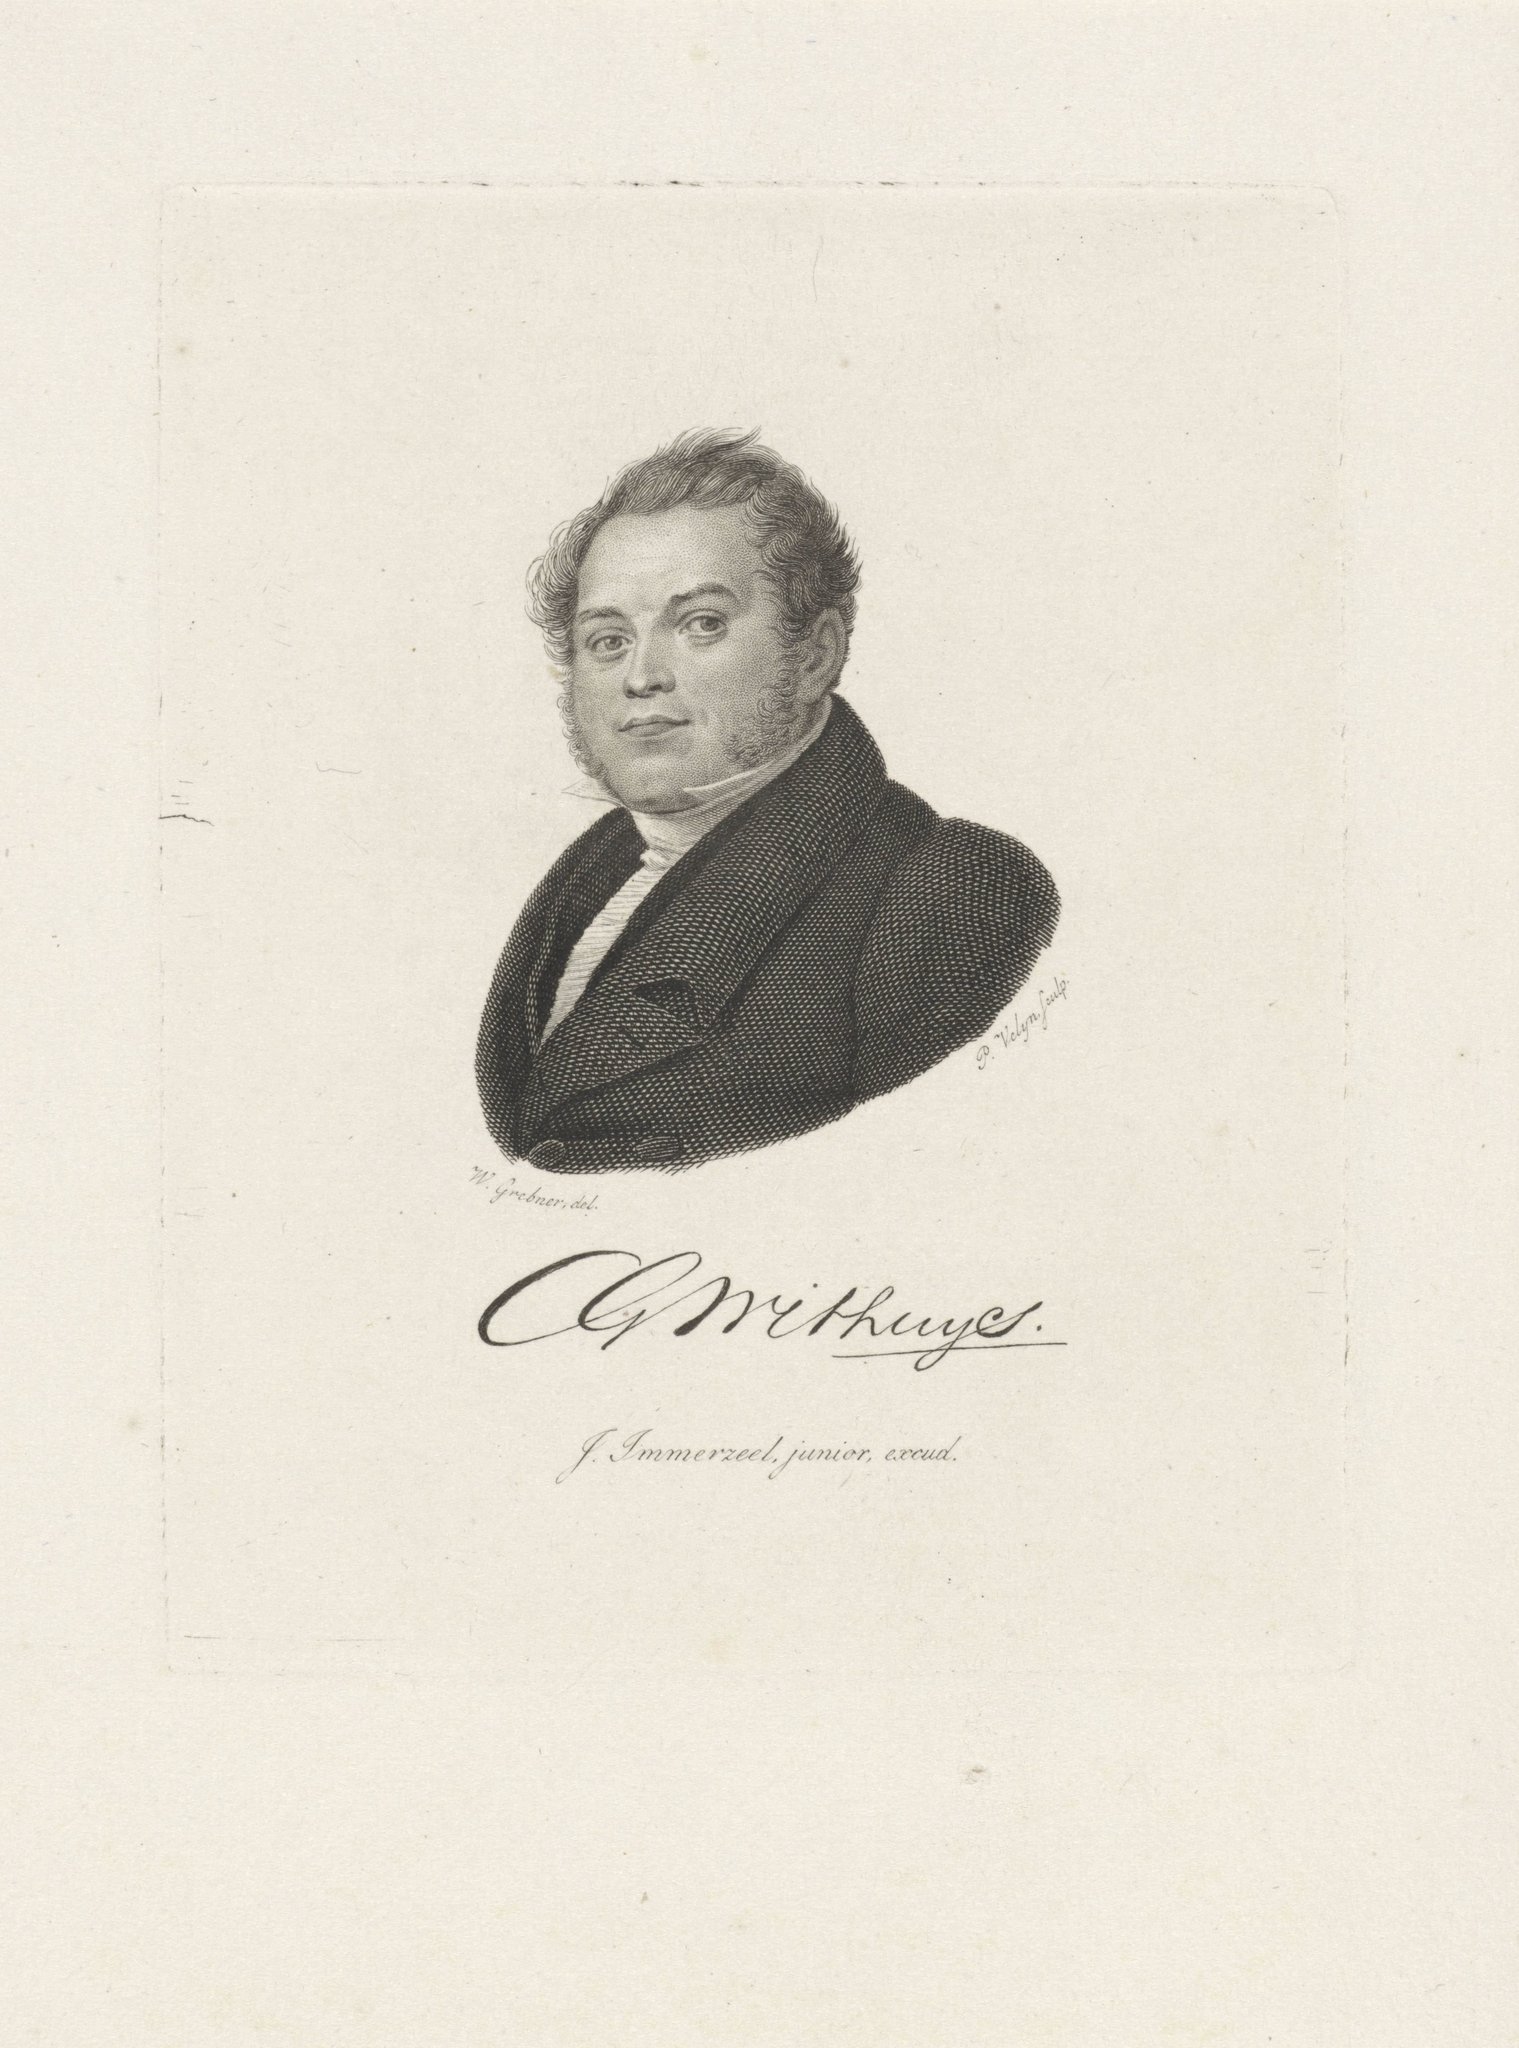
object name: print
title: Portret van Carel Godfried Withuys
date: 1831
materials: paper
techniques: engraving, etching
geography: netherlands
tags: amsterdam, the hague, publisher, carel godfried withuys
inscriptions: collector's mark: Lugt 2228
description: Prent volgens Van Someren gebruikt in: Nederlandsche Muzen-Almanak. Rotterdam: J. Immerzeel, 1831.